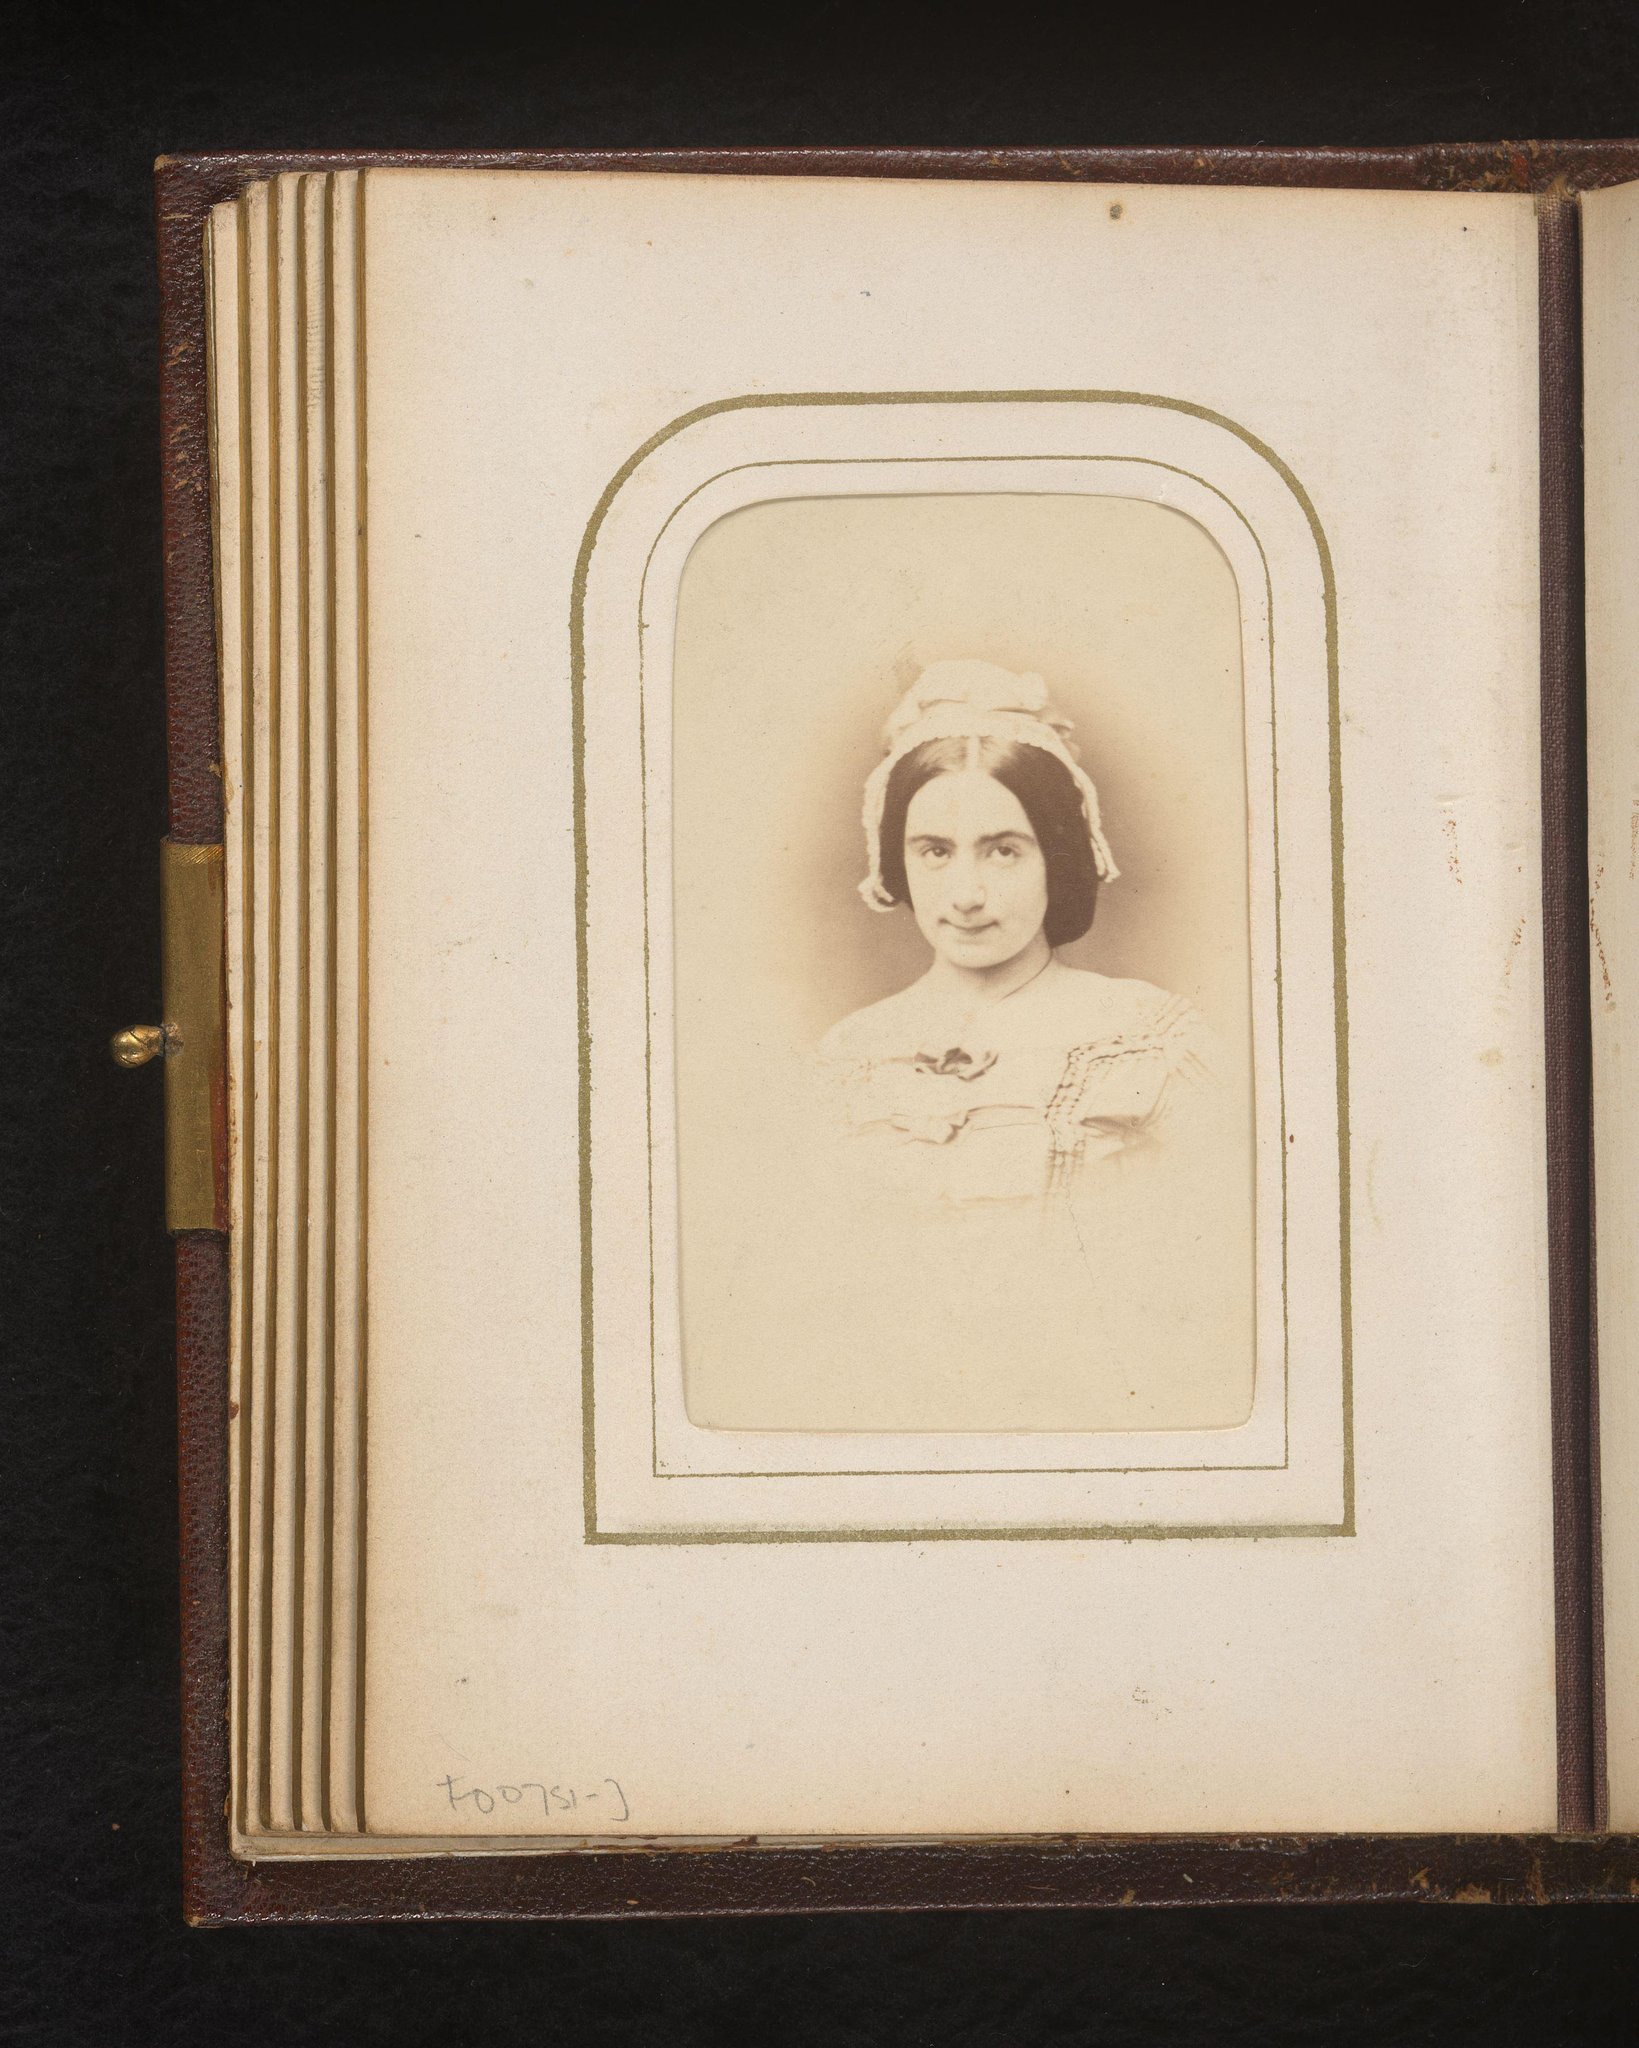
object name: carte de visite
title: Portret van een jonge vrouw met witte muts op het hoofd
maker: Anonymous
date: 1860-1900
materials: cardboard, photographic support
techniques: albumen print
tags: adolescent, young woman, maiden, historical persons, head-gear: cap